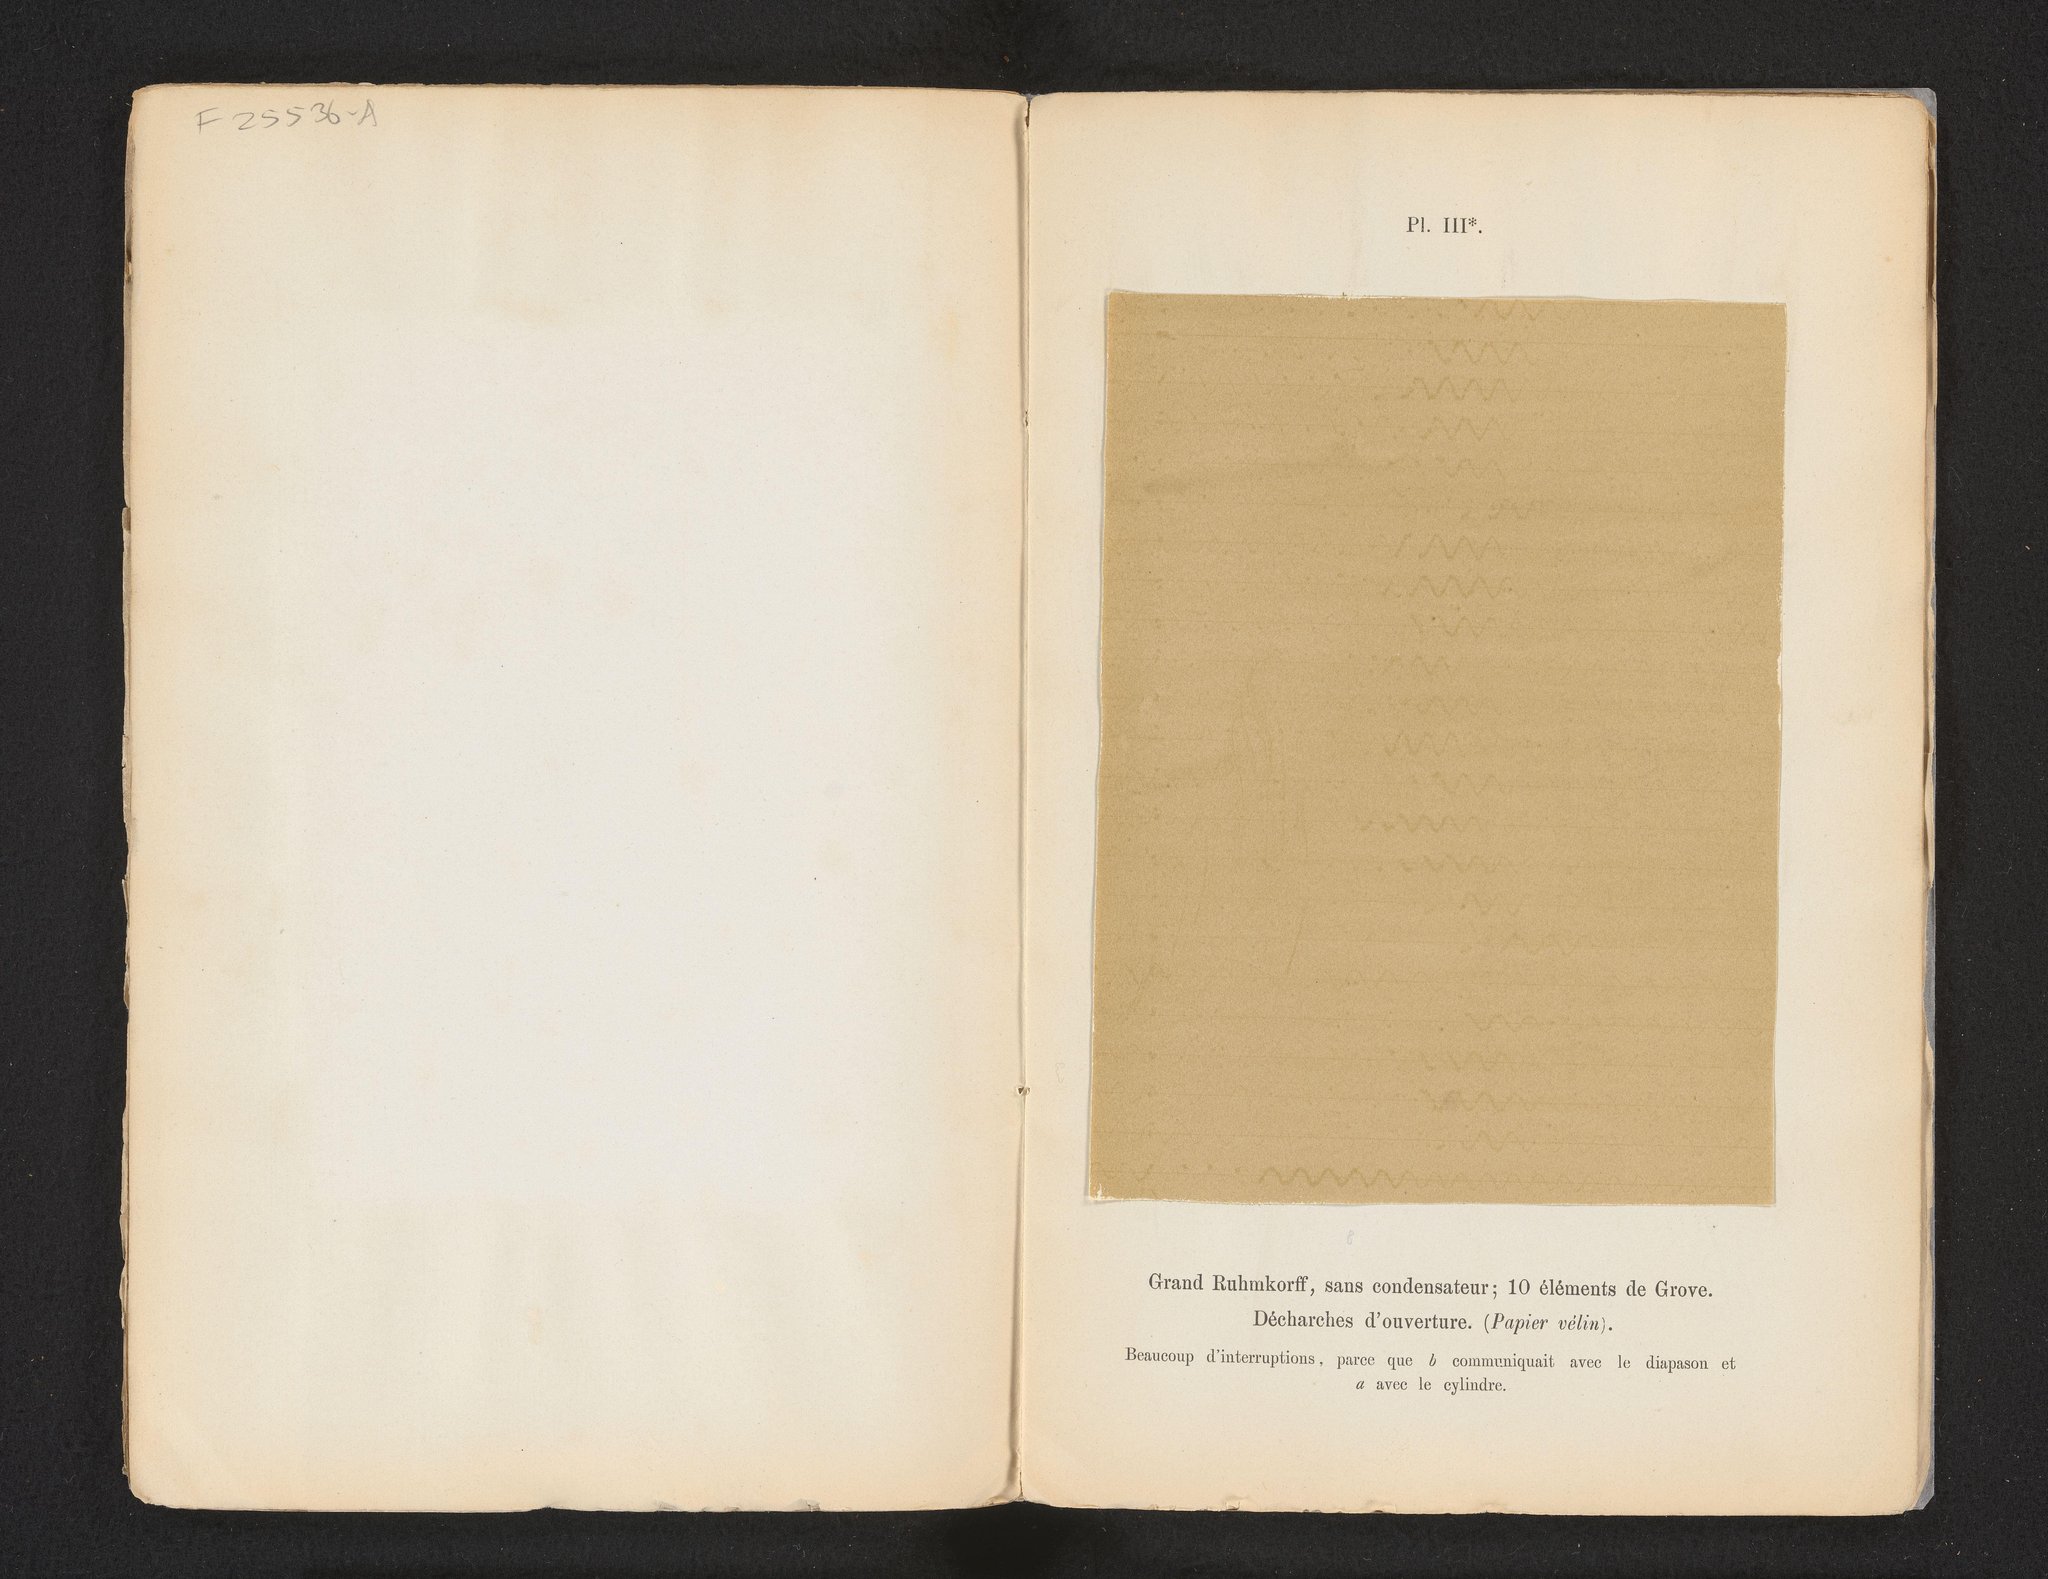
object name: page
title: Registratie van electriciteitsgolven opgewekt door een vonkinductor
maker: willem cornelis van dijk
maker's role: painter, print maker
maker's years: 1826-1881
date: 1865-1870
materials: paper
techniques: albumen print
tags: electrical phenomena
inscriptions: number: ‘Pl. II*.’, inscription: ‘Beaucoup d'interruptions, parce que b communiquait avec le diapason et/ a avec le cylindre.’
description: Foto op vijfde ongenummerde pagina na pagina 368.